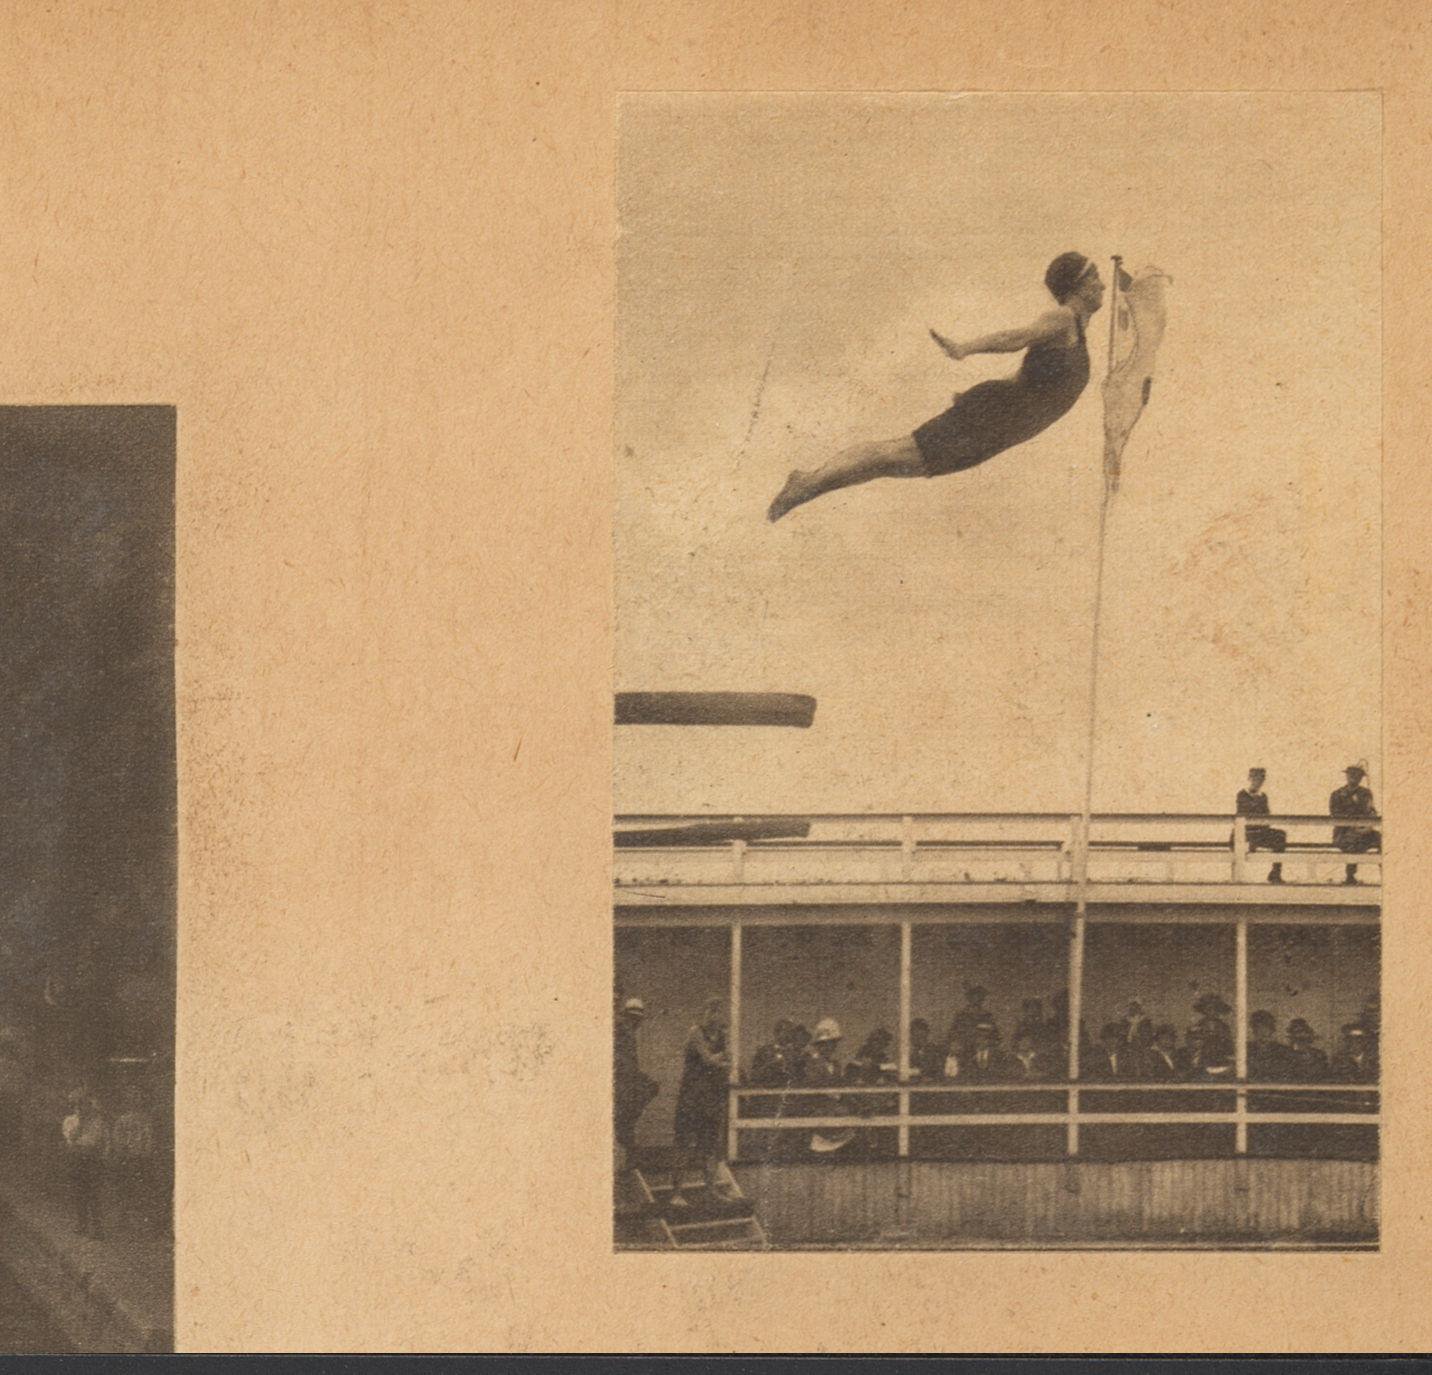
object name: photograph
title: Vrouw maakt zweefduik in zwembad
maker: Anonymous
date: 1900-1920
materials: paper, ink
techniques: rotogravure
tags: diving (movement in water), swimming (sport)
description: Onderdeel van Familiealbum met foto's van een familie in de voormalige kolonie Nederlands-Indië en van een suikerfabriek in Purworejo.